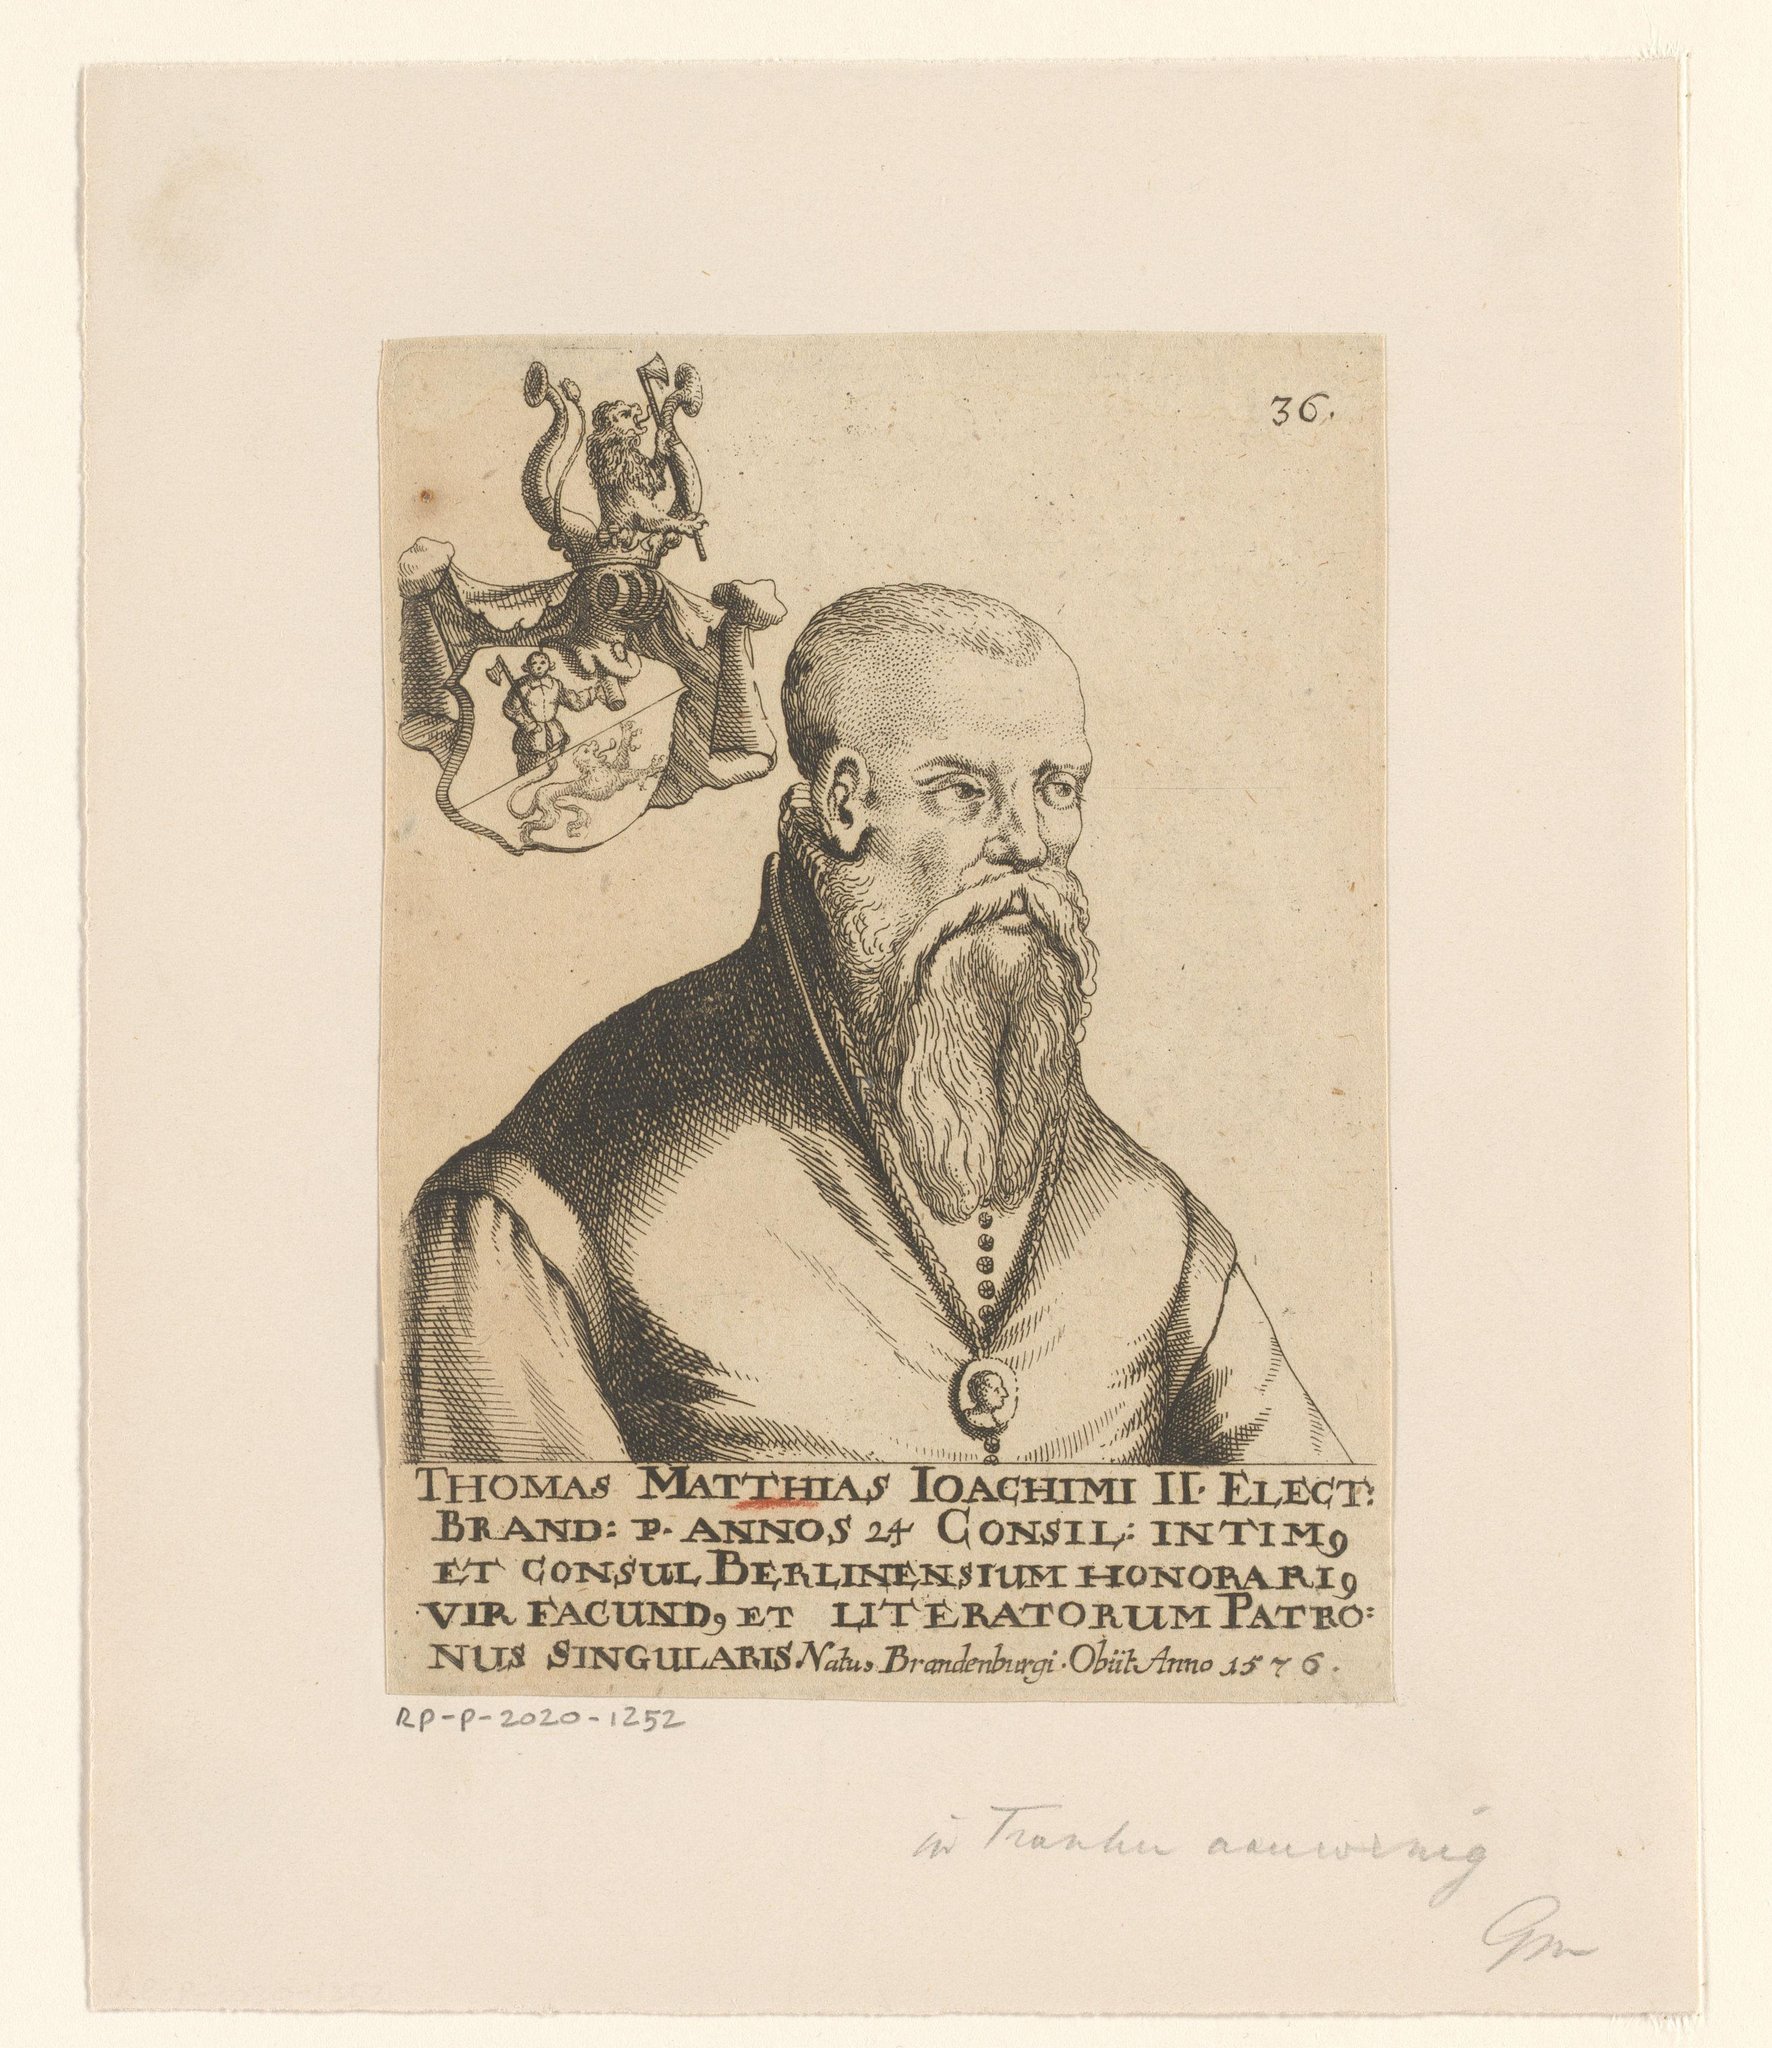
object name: print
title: Portretten van illustere mannen uit de omgeving van de mark Brandenburg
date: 1671-1751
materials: paper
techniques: engraving, etching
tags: mayor, burgomaster, historical persons, politician, e.g. party leader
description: De prent is uitgegeven als onderdeel van een serie. Later is de prent mogelijk ook als boekillustratie gebruikt in: Küster, Georg Gottfried. Martin Friedrich Seidels Bilder-Sammlung in welcher hundert, gröstentheils in der Mark Brandenburg (…). Berlijn: Buchladen bey der Real-Schule, 1751. Het is onduidelijk tot welke uitgave de huidige prent behoort.